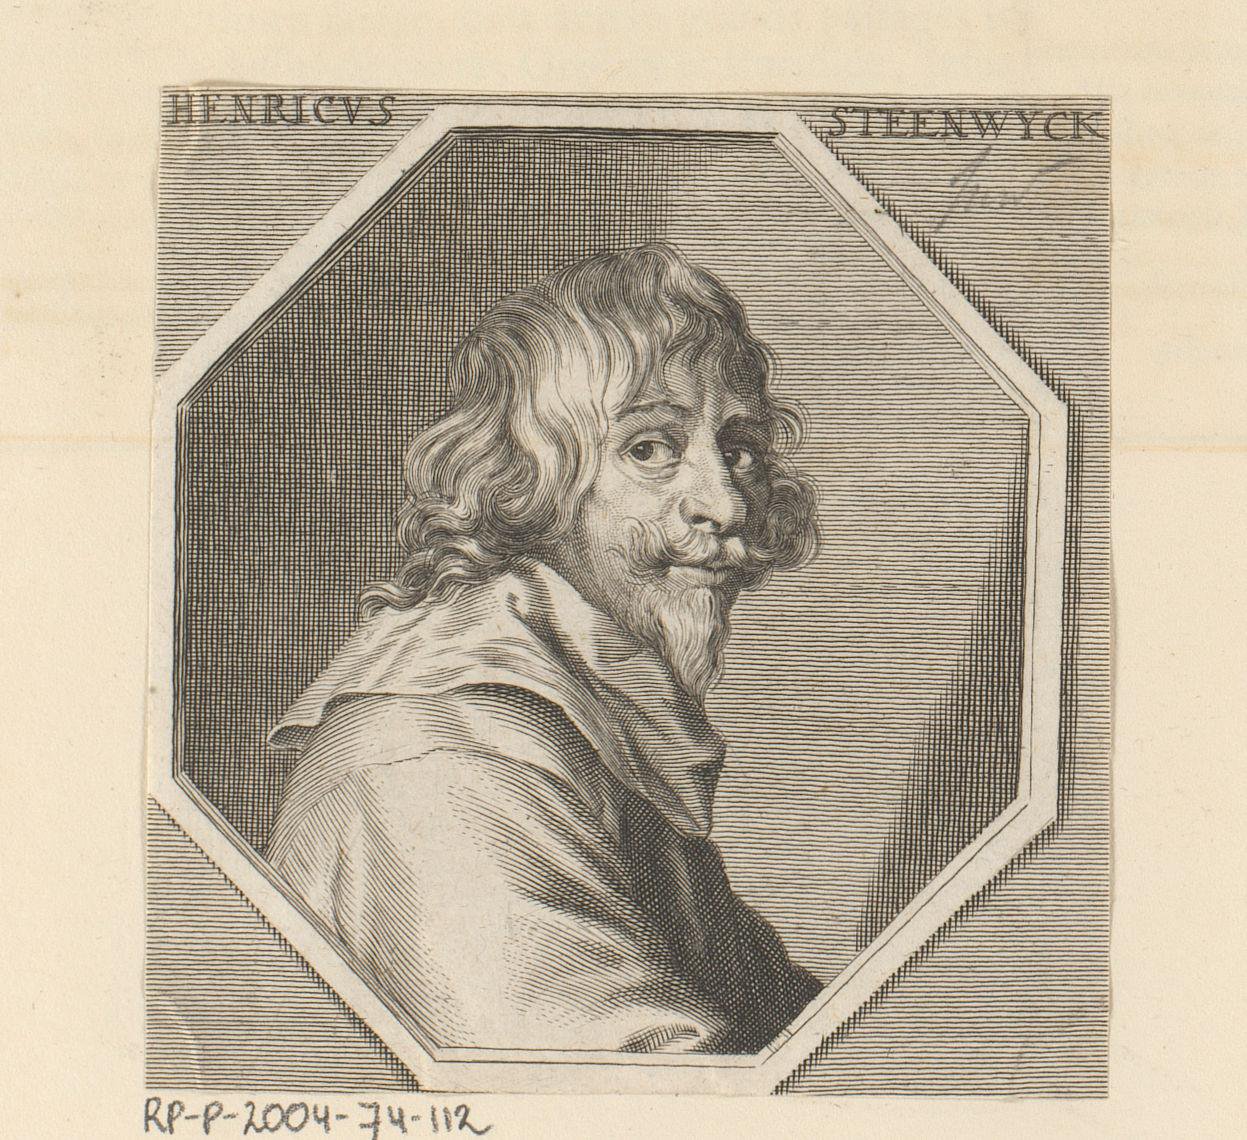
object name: print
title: Henricus Steenwyck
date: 1675-1679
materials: paper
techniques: engraving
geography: nuremberg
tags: painter, hendrik van steenwijck (i), historical persons, portrait, self-portrait of painter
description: Prent uit: Sandrart, Joachim von. Teutsche Academie der Edlen Bau- Bild- und Mahlerey-Künste (...). Neurenberg: Jakob von Sandrart, [1675-1679], dl. 1, p. 298. Latere staat van de prent gebruikt in: Sandrart, Joachim von. Teutsche Academie der Bau- Bildhauer- und Maler-Kunst: worinn die Regeln und Lehrsätze dieser Künste gegeben. 14 dln. Neurenberg: erven Johann Andreas Endter, [1774], dl. 7, p. FF. De samensteller heeft deze prent in het album geplakt als illustratie bij: Pilkington, Matthew en Johann Heinrich Füssli. A dictionary of painters, from the revival of the art to the present period. 4 dln. Londen: John Crowder, 1805, dl. 3, p. 525.